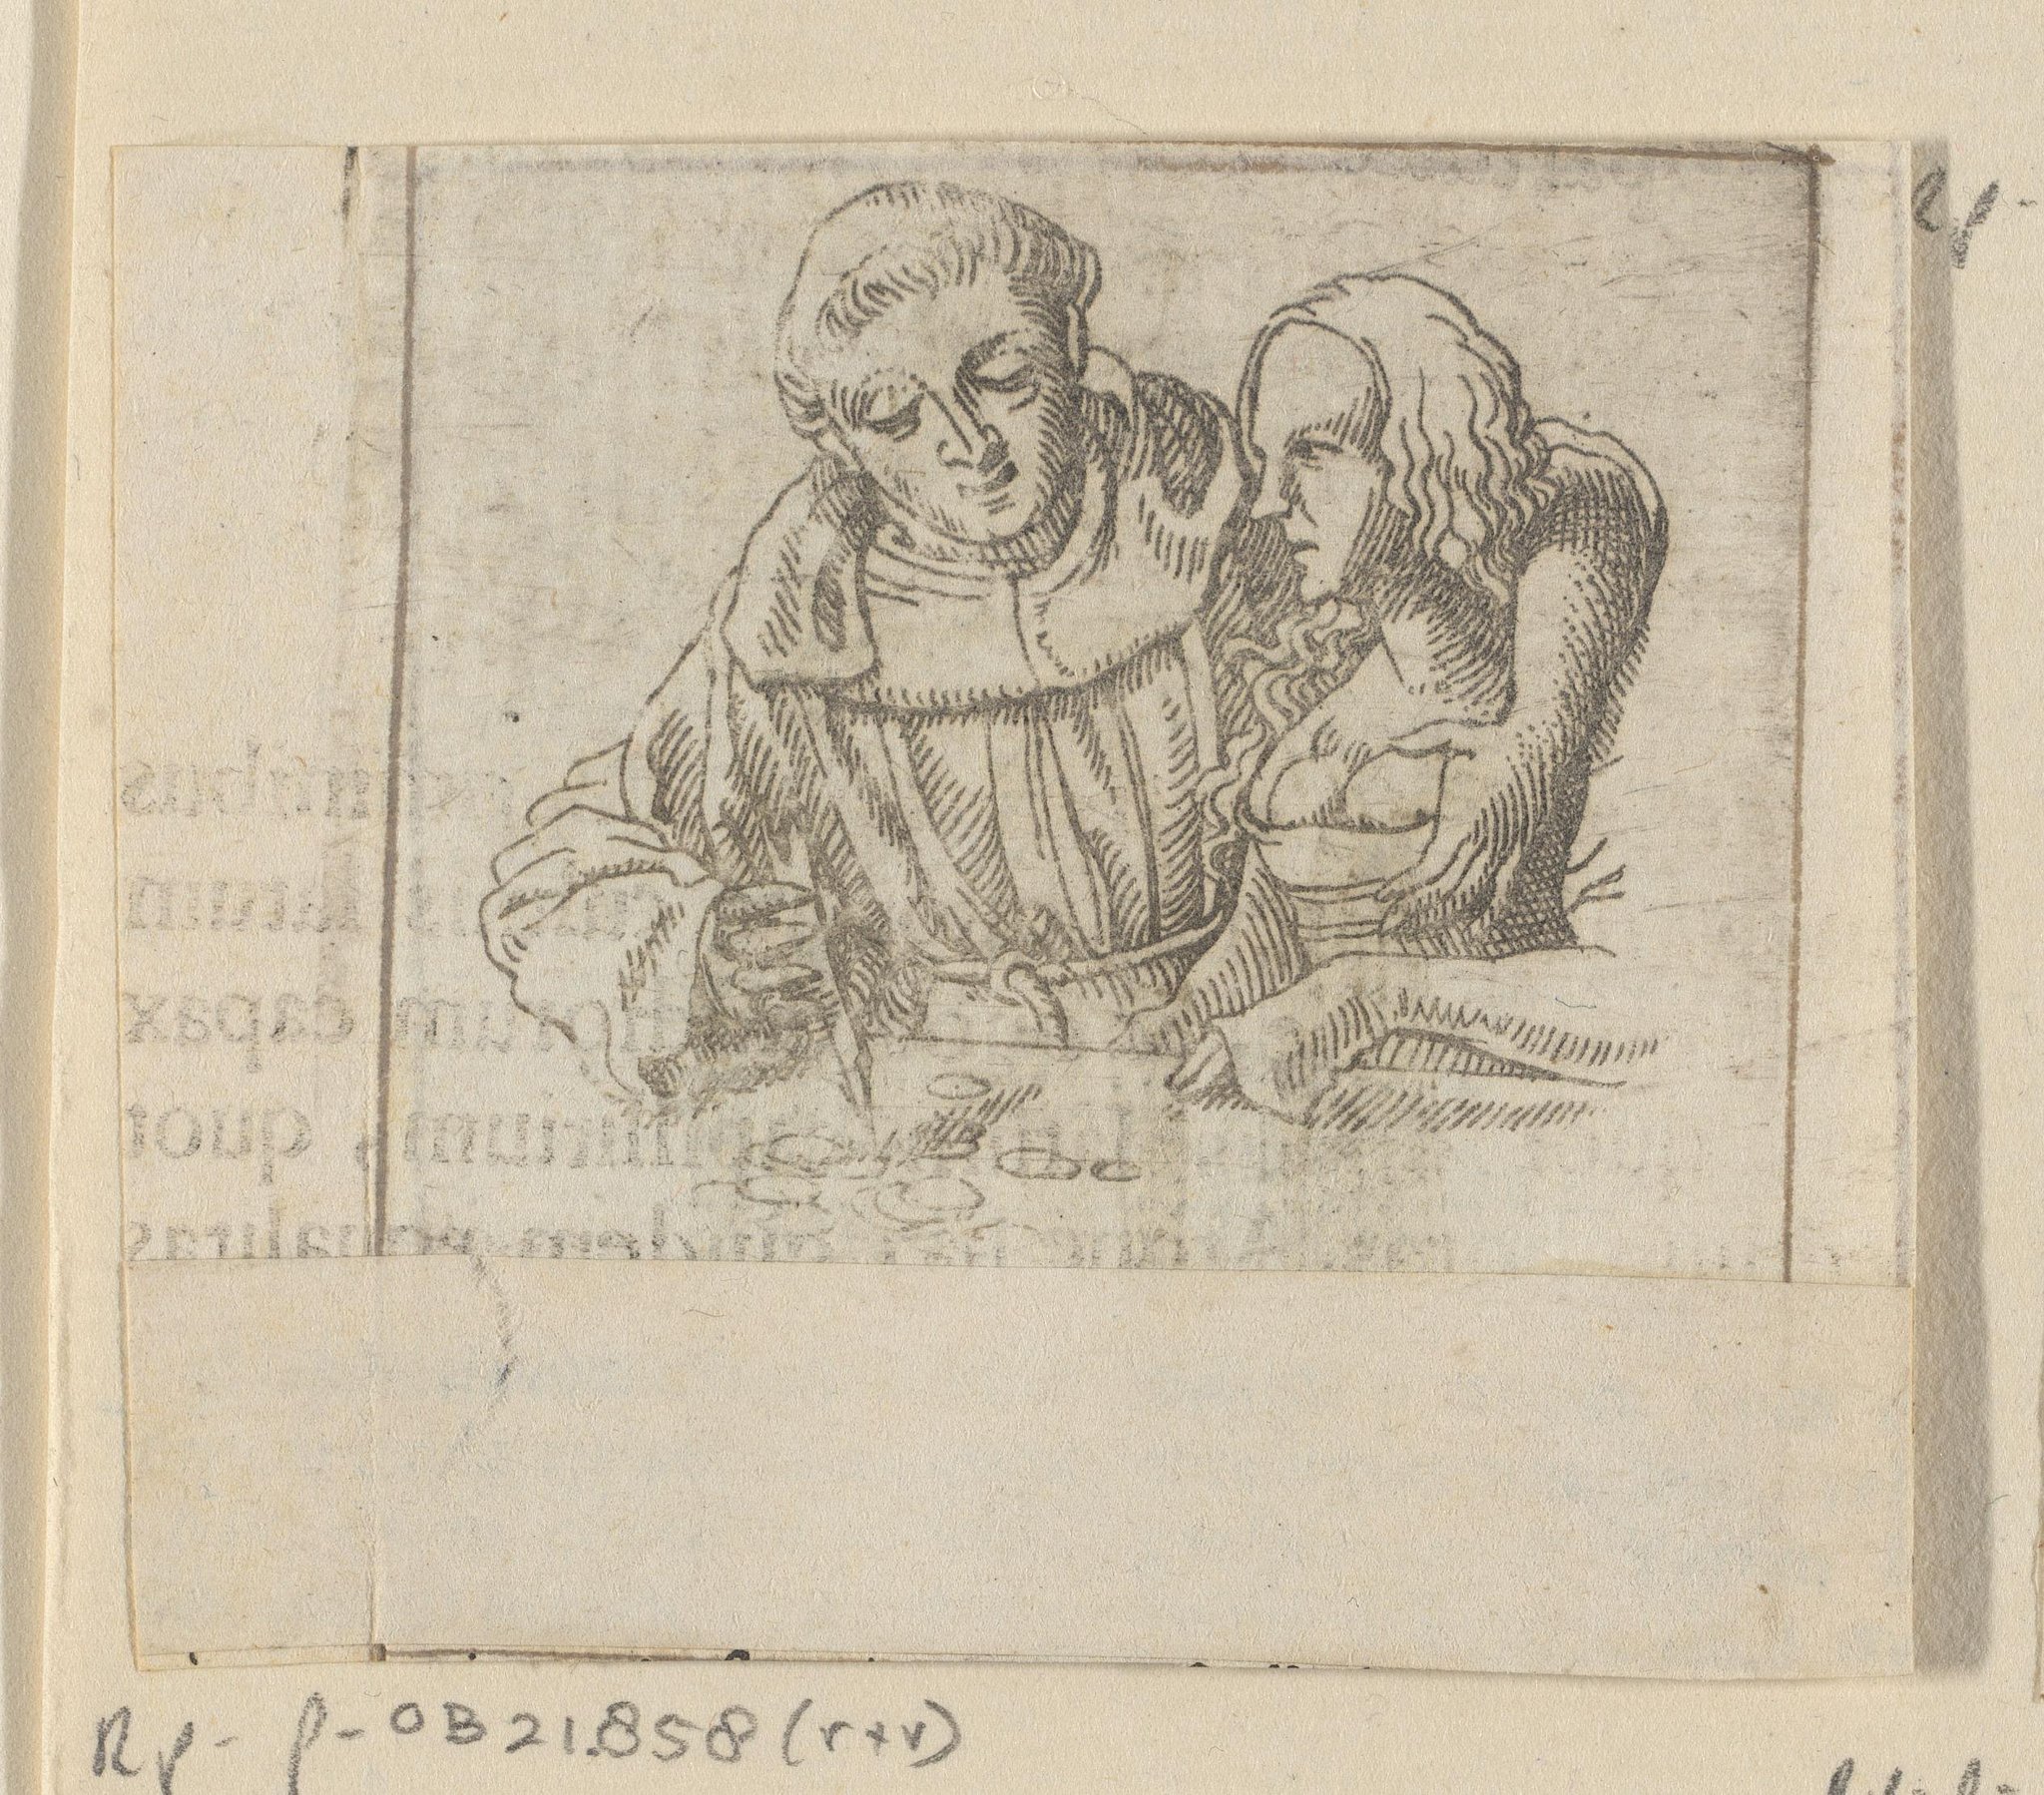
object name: print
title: Illustraties uit de Lof der Zotheid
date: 1516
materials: paper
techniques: etching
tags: desiderius erasmus, monk(s), friar(s), folly, foolishness; 'pazzia', 'sciocchezza', 'stoltitia' (ripa), indecency, impudence; 'sfacciatigine' (ripa), money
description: Prent afkomstig uit: Erasmus, Desiderius. Morias enkomion (...). Bazel: Johann Rudolf Genath, 1676. De prenten hierin zijn naar tekeningen die Hans en Ambrosius Holbein maakten voor de theoloog Oswald Myconius in diens uitgave van de Moriae encomium (Lof der Zotheid) van 1516.